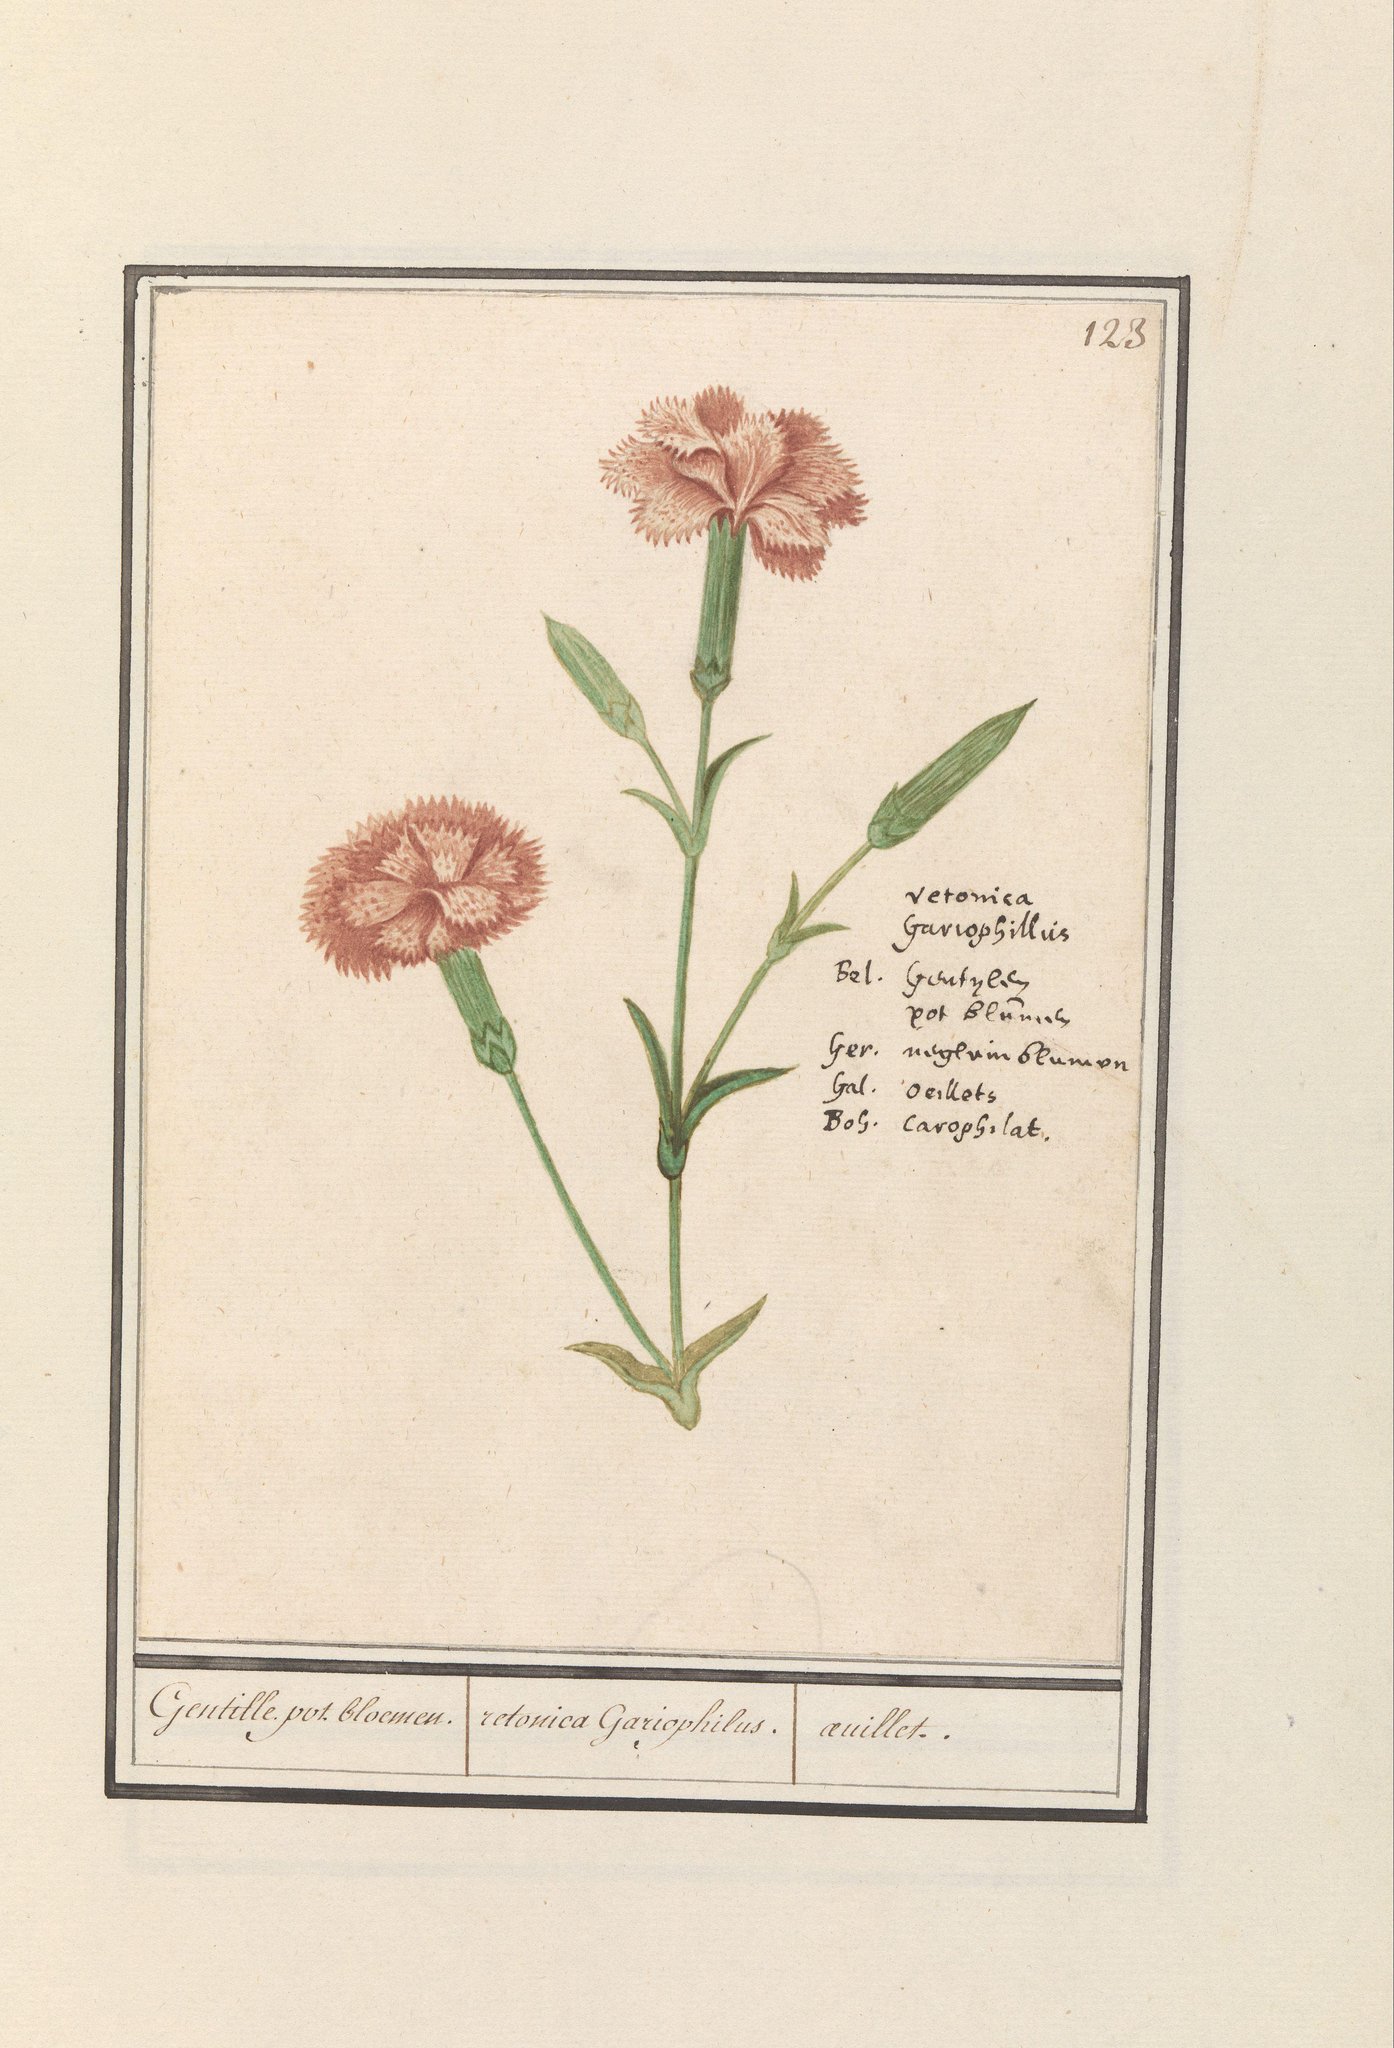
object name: drawing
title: Gentille. pot. bloemen. / retonica Gariophilus. / oeuillet.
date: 1596-1610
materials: paint, ink, paper, pencil, watercolor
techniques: brush, pen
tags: flowers: carnation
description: Anjer. Rechtsboven genummerd: 123. Met de naam in vijf talen. Onderdeel van het tweede album met tekeningen van bloemen en planten. Negende van twaalf albums met tekeningen van dieren, vogels en planten bekend rond 1600, gemaakt in opdracht van keizer Rudolf II. Met toelichting in Nederlands, Latijn en Frans.